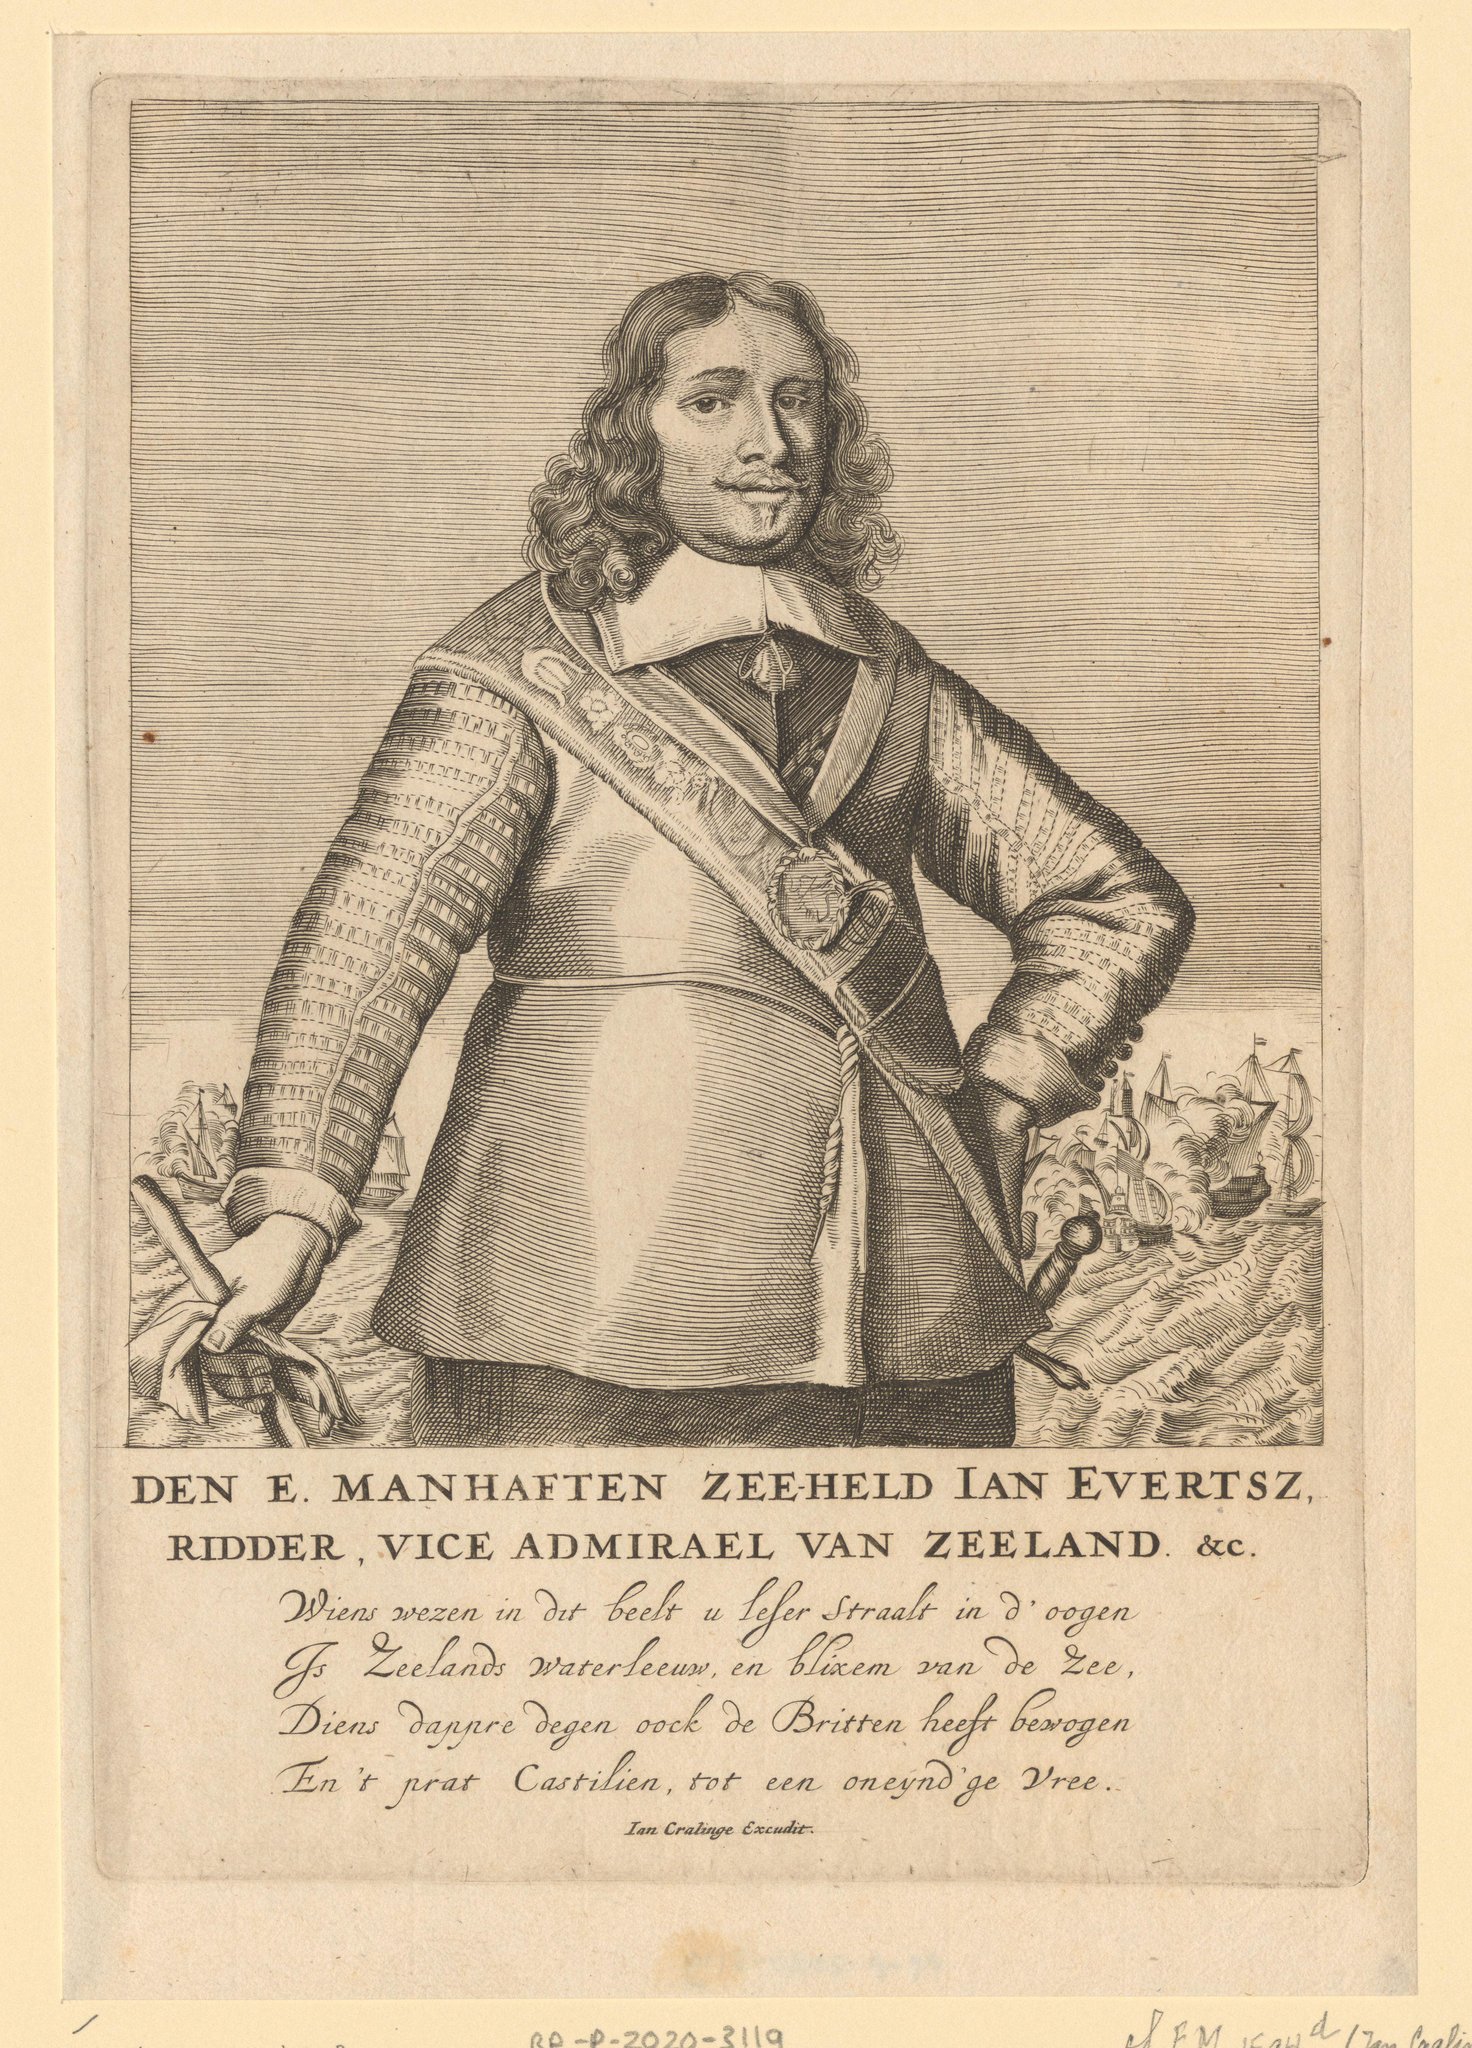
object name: print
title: Portret van Johan Evertsen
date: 1655-1673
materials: paper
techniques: engraving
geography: northern netherlands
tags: flushing, battle (+ naval force), historical persons, commander-in-chief, admiral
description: Met vierregelig lofdicht in het Nederlands.